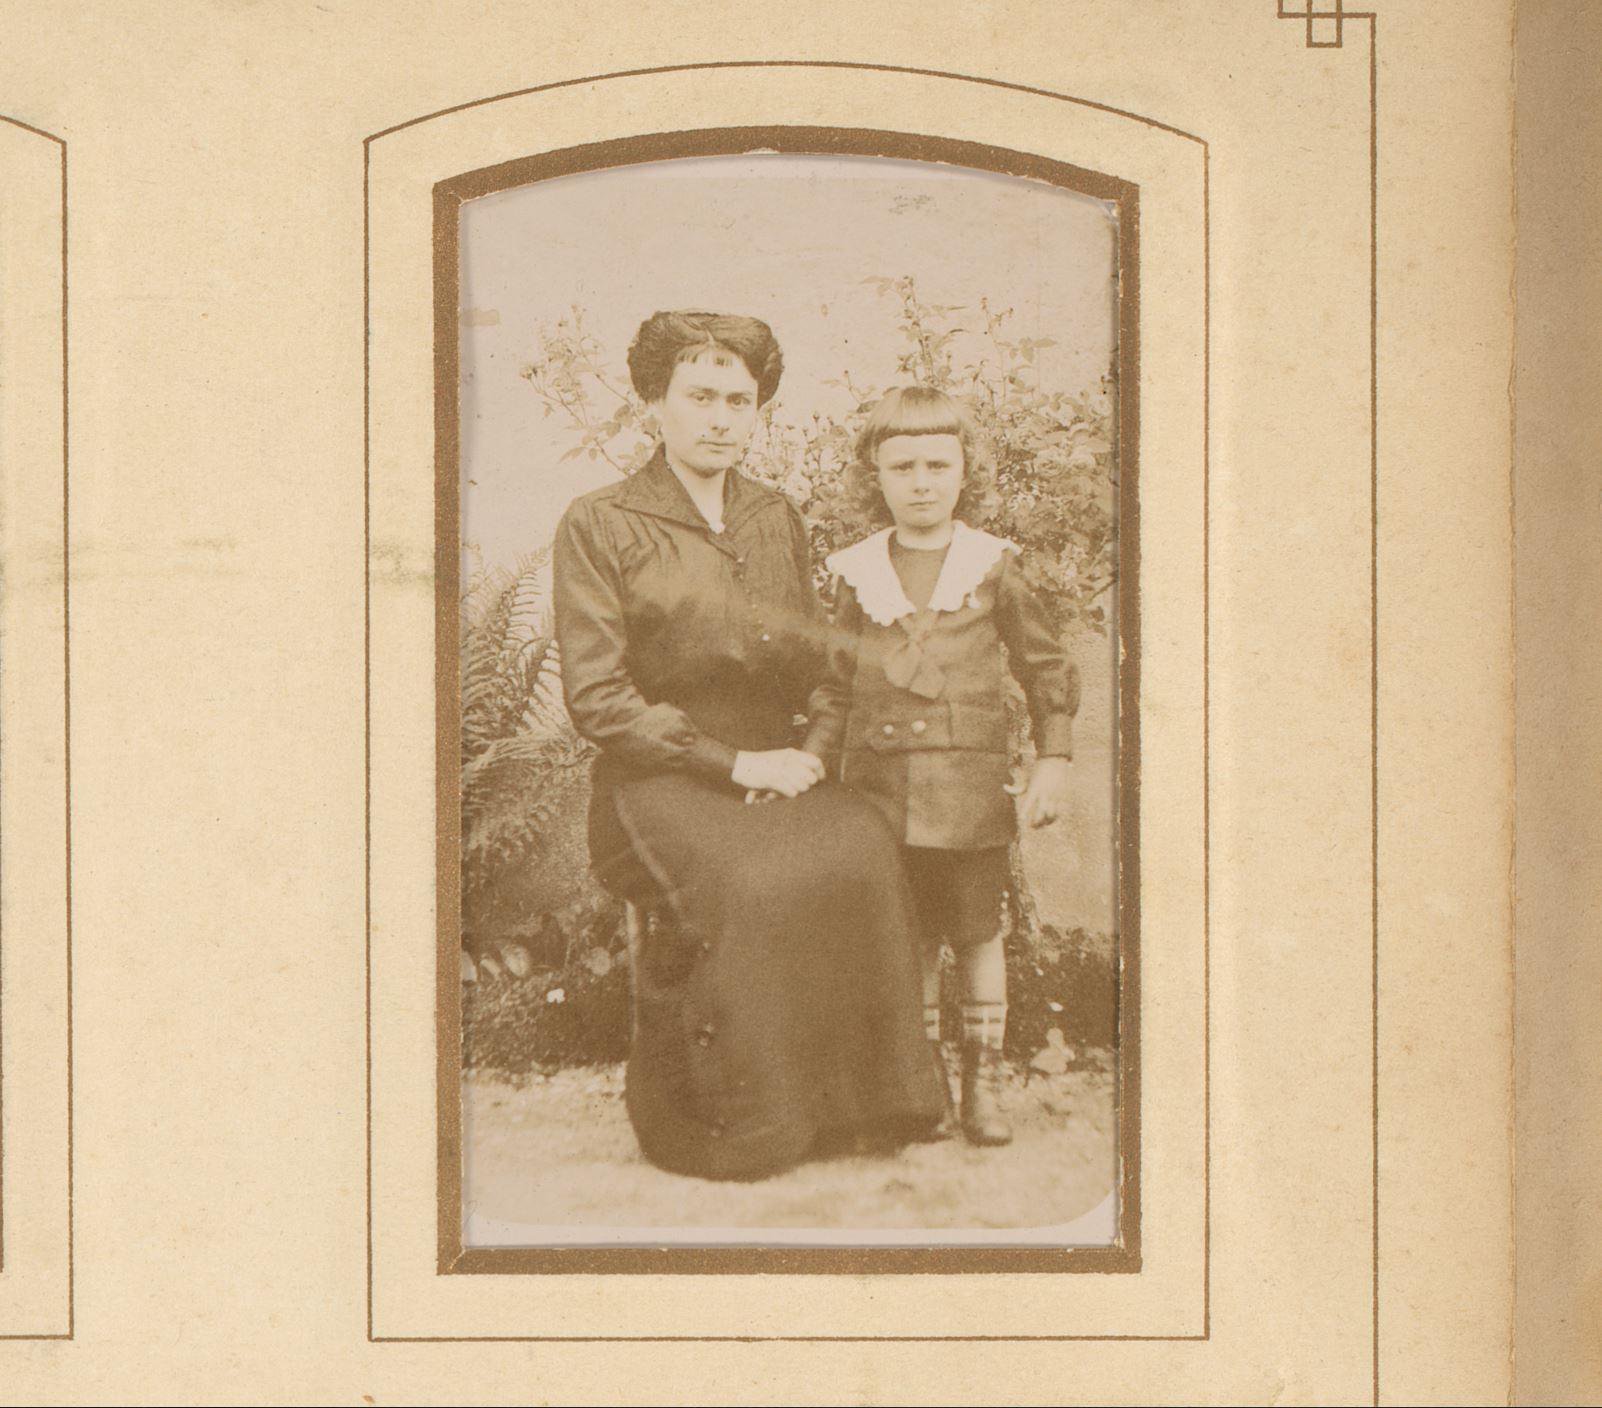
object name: album leaf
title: Portret van een moeder met kind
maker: Anonymous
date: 1880-1920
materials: cardboard, photographic support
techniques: gelatin silver print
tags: mother and baby or young child